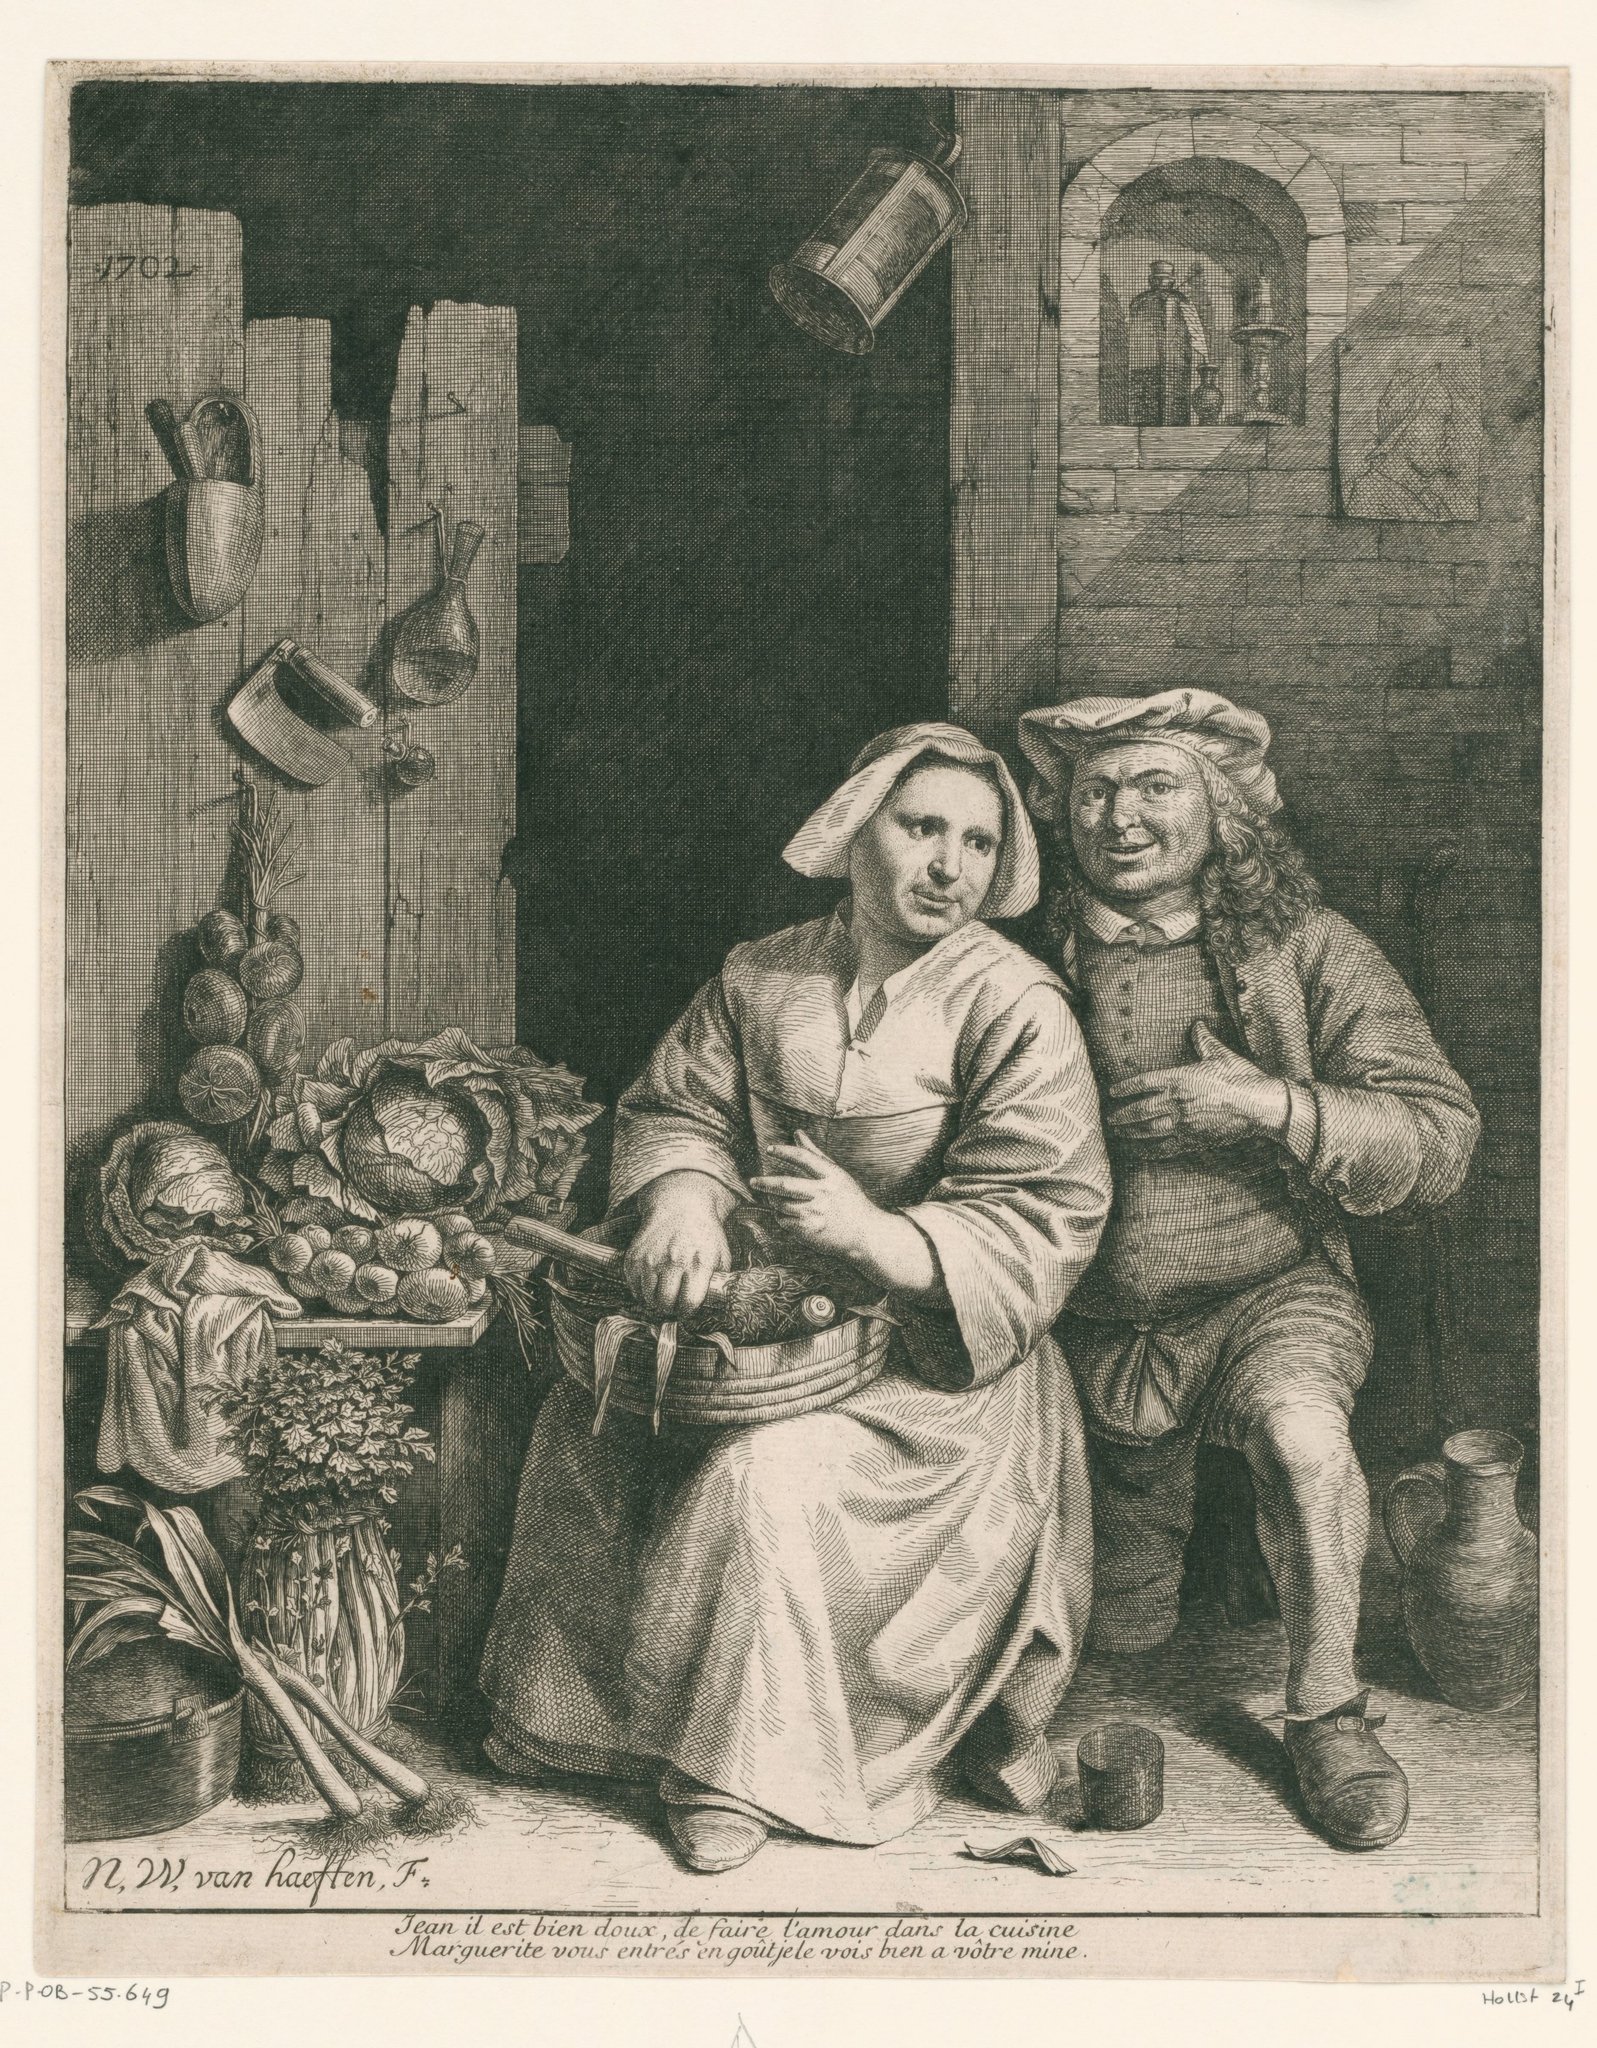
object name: print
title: Paar in een keukeninterieur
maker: nicolaes van haeften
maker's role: draughtsman, painter, print maker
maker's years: 1653-1715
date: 1702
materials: paper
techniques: etching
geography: paris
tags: vegetables, kitchen-interior, courting, cleaning vegetables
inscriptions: collector's mark: Lugt 2165, name: ‘Boerner KDJ’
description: Een man knielend bij een vrouw in een interieur met diverse groenten op een tafel. Met onderschrift: Jean il est bien doux, de faire lámour dans la cuisine/ Marguerite vous entrés en goût je le vois bien a vôtre mine.